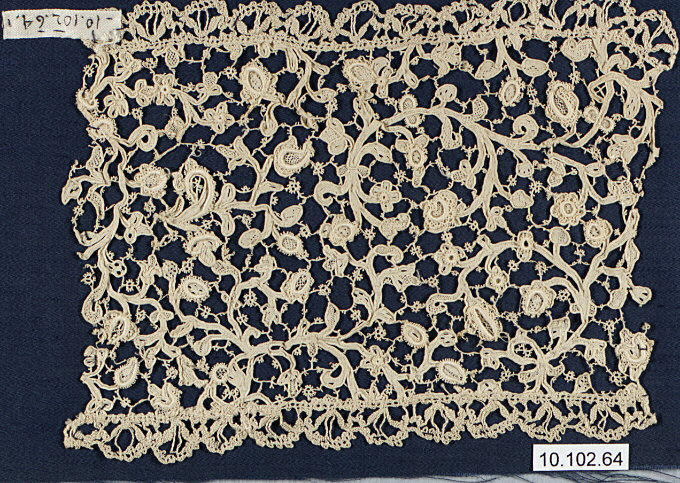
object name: fragment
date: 1601-1700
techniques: lace